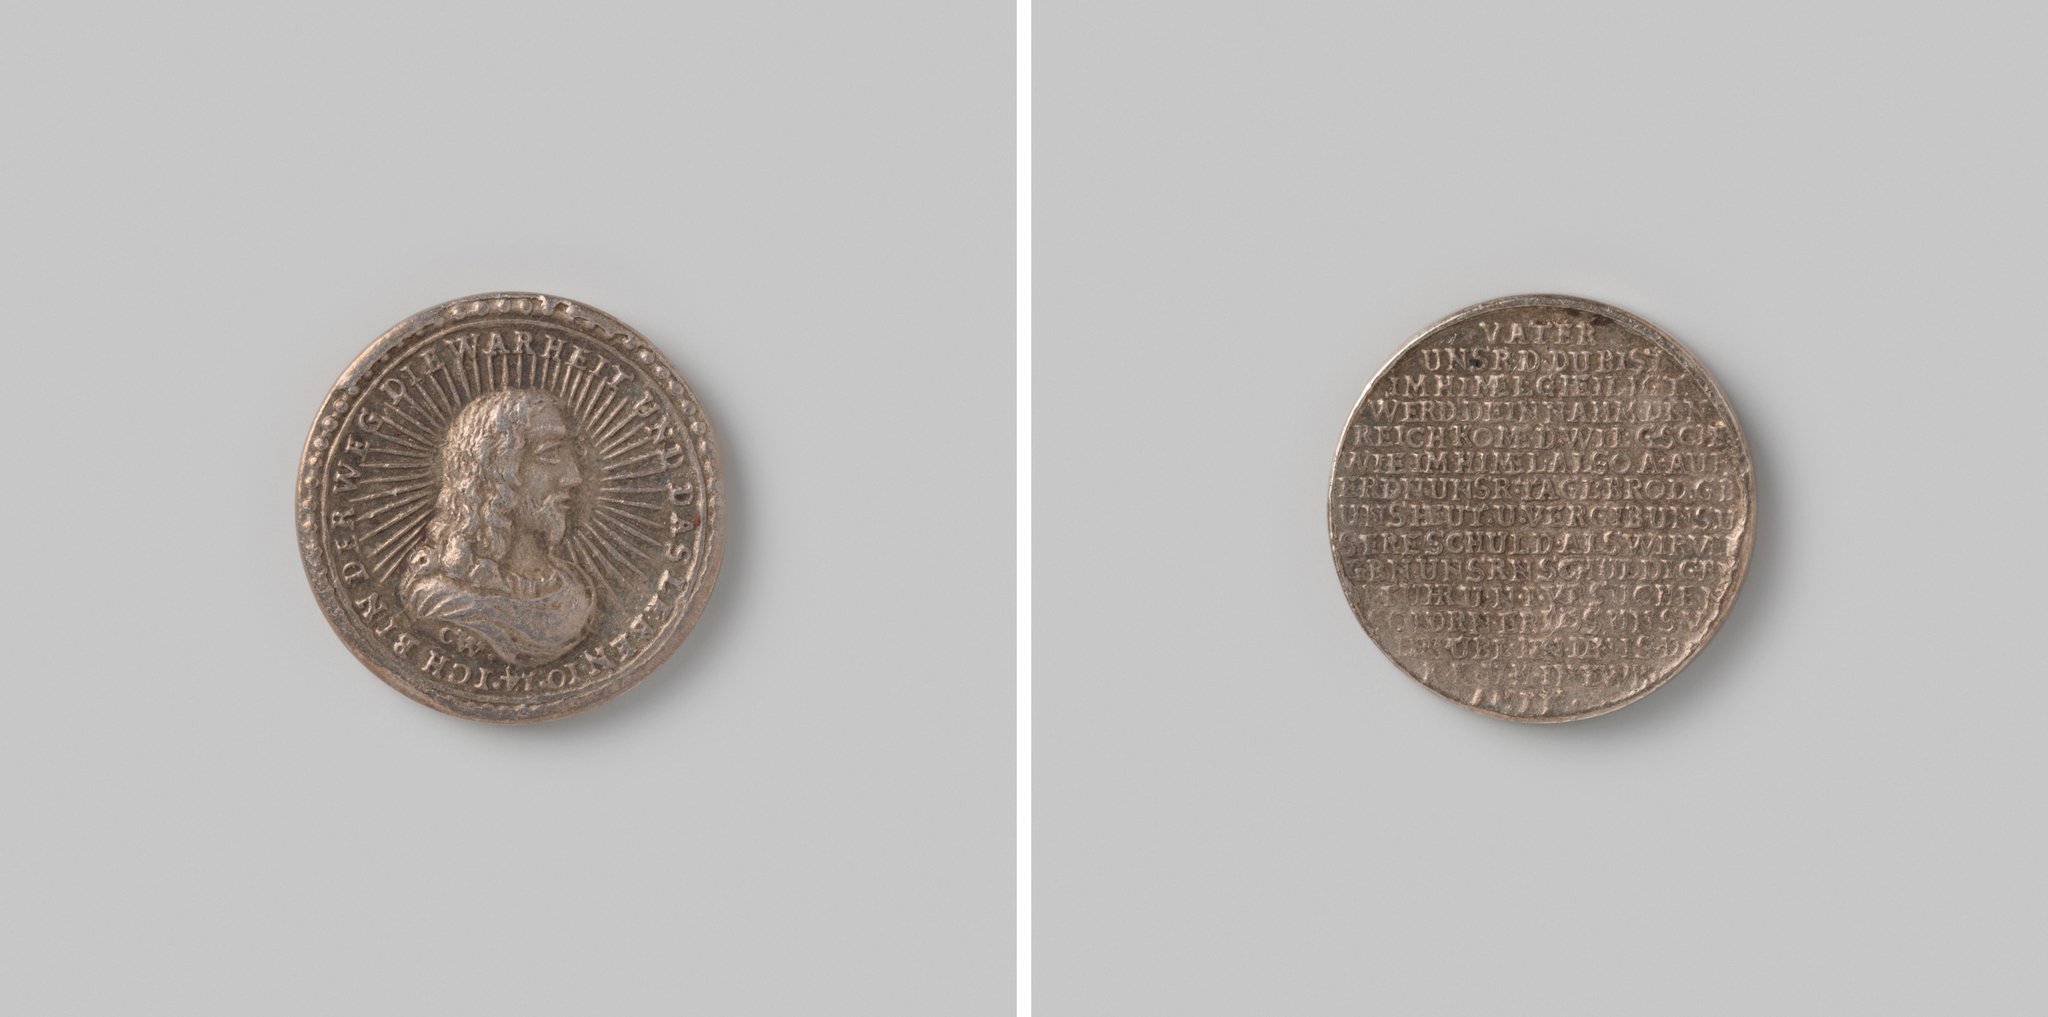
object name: history medal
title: Duitse miniatuurpenning met Onze Vader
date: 1600-1750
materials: silver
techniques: striking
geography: germany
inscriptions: signature: ‘CW.’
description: Kleine zilveren penning, op de voorzijde het stralende borstbeeld van Jesus naar rechts met omschrift, op de keerzijde het Onze Vader in vijftien regels.